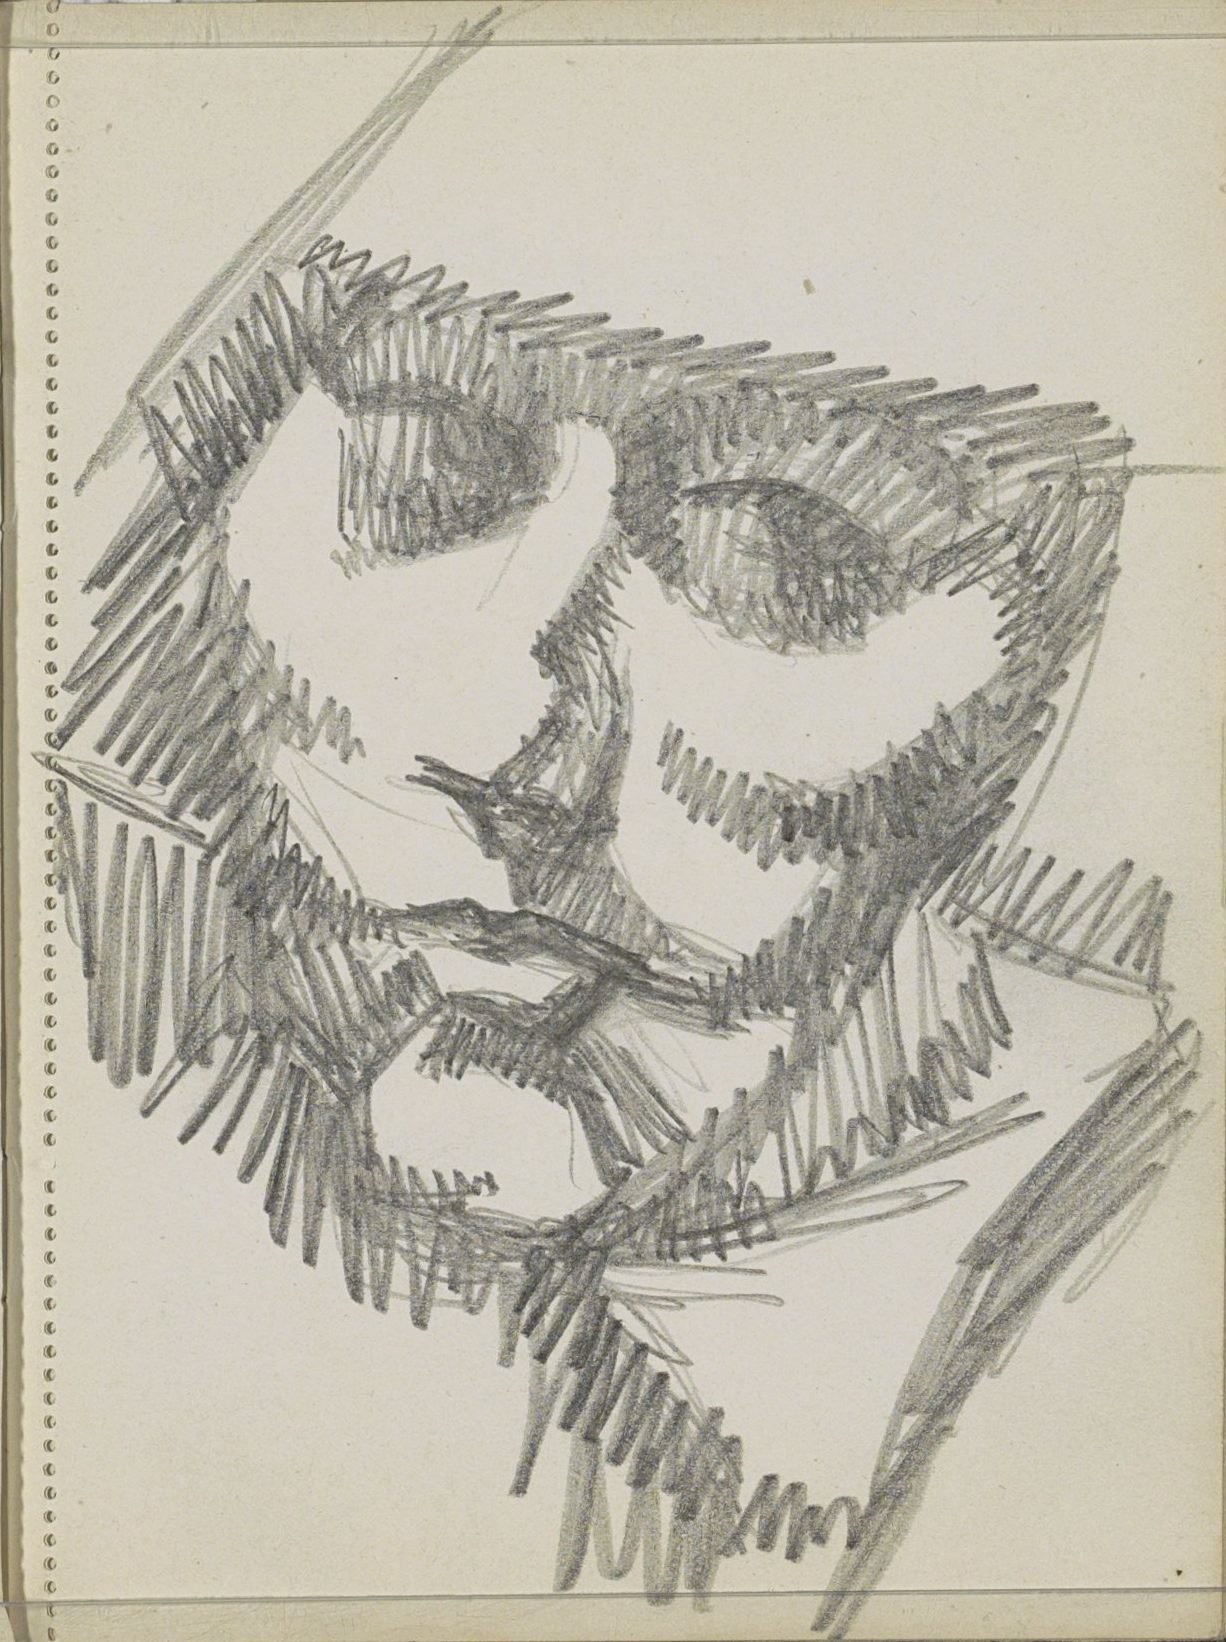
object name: sketchbook leaf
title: Kop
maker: reijer stolk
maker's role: draughtsman, print maker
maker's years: 1896-1945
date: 1906-1945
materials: paper, pencil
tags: head (human)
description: Blad 2 recto uit een schetsboek met 53 bladen.